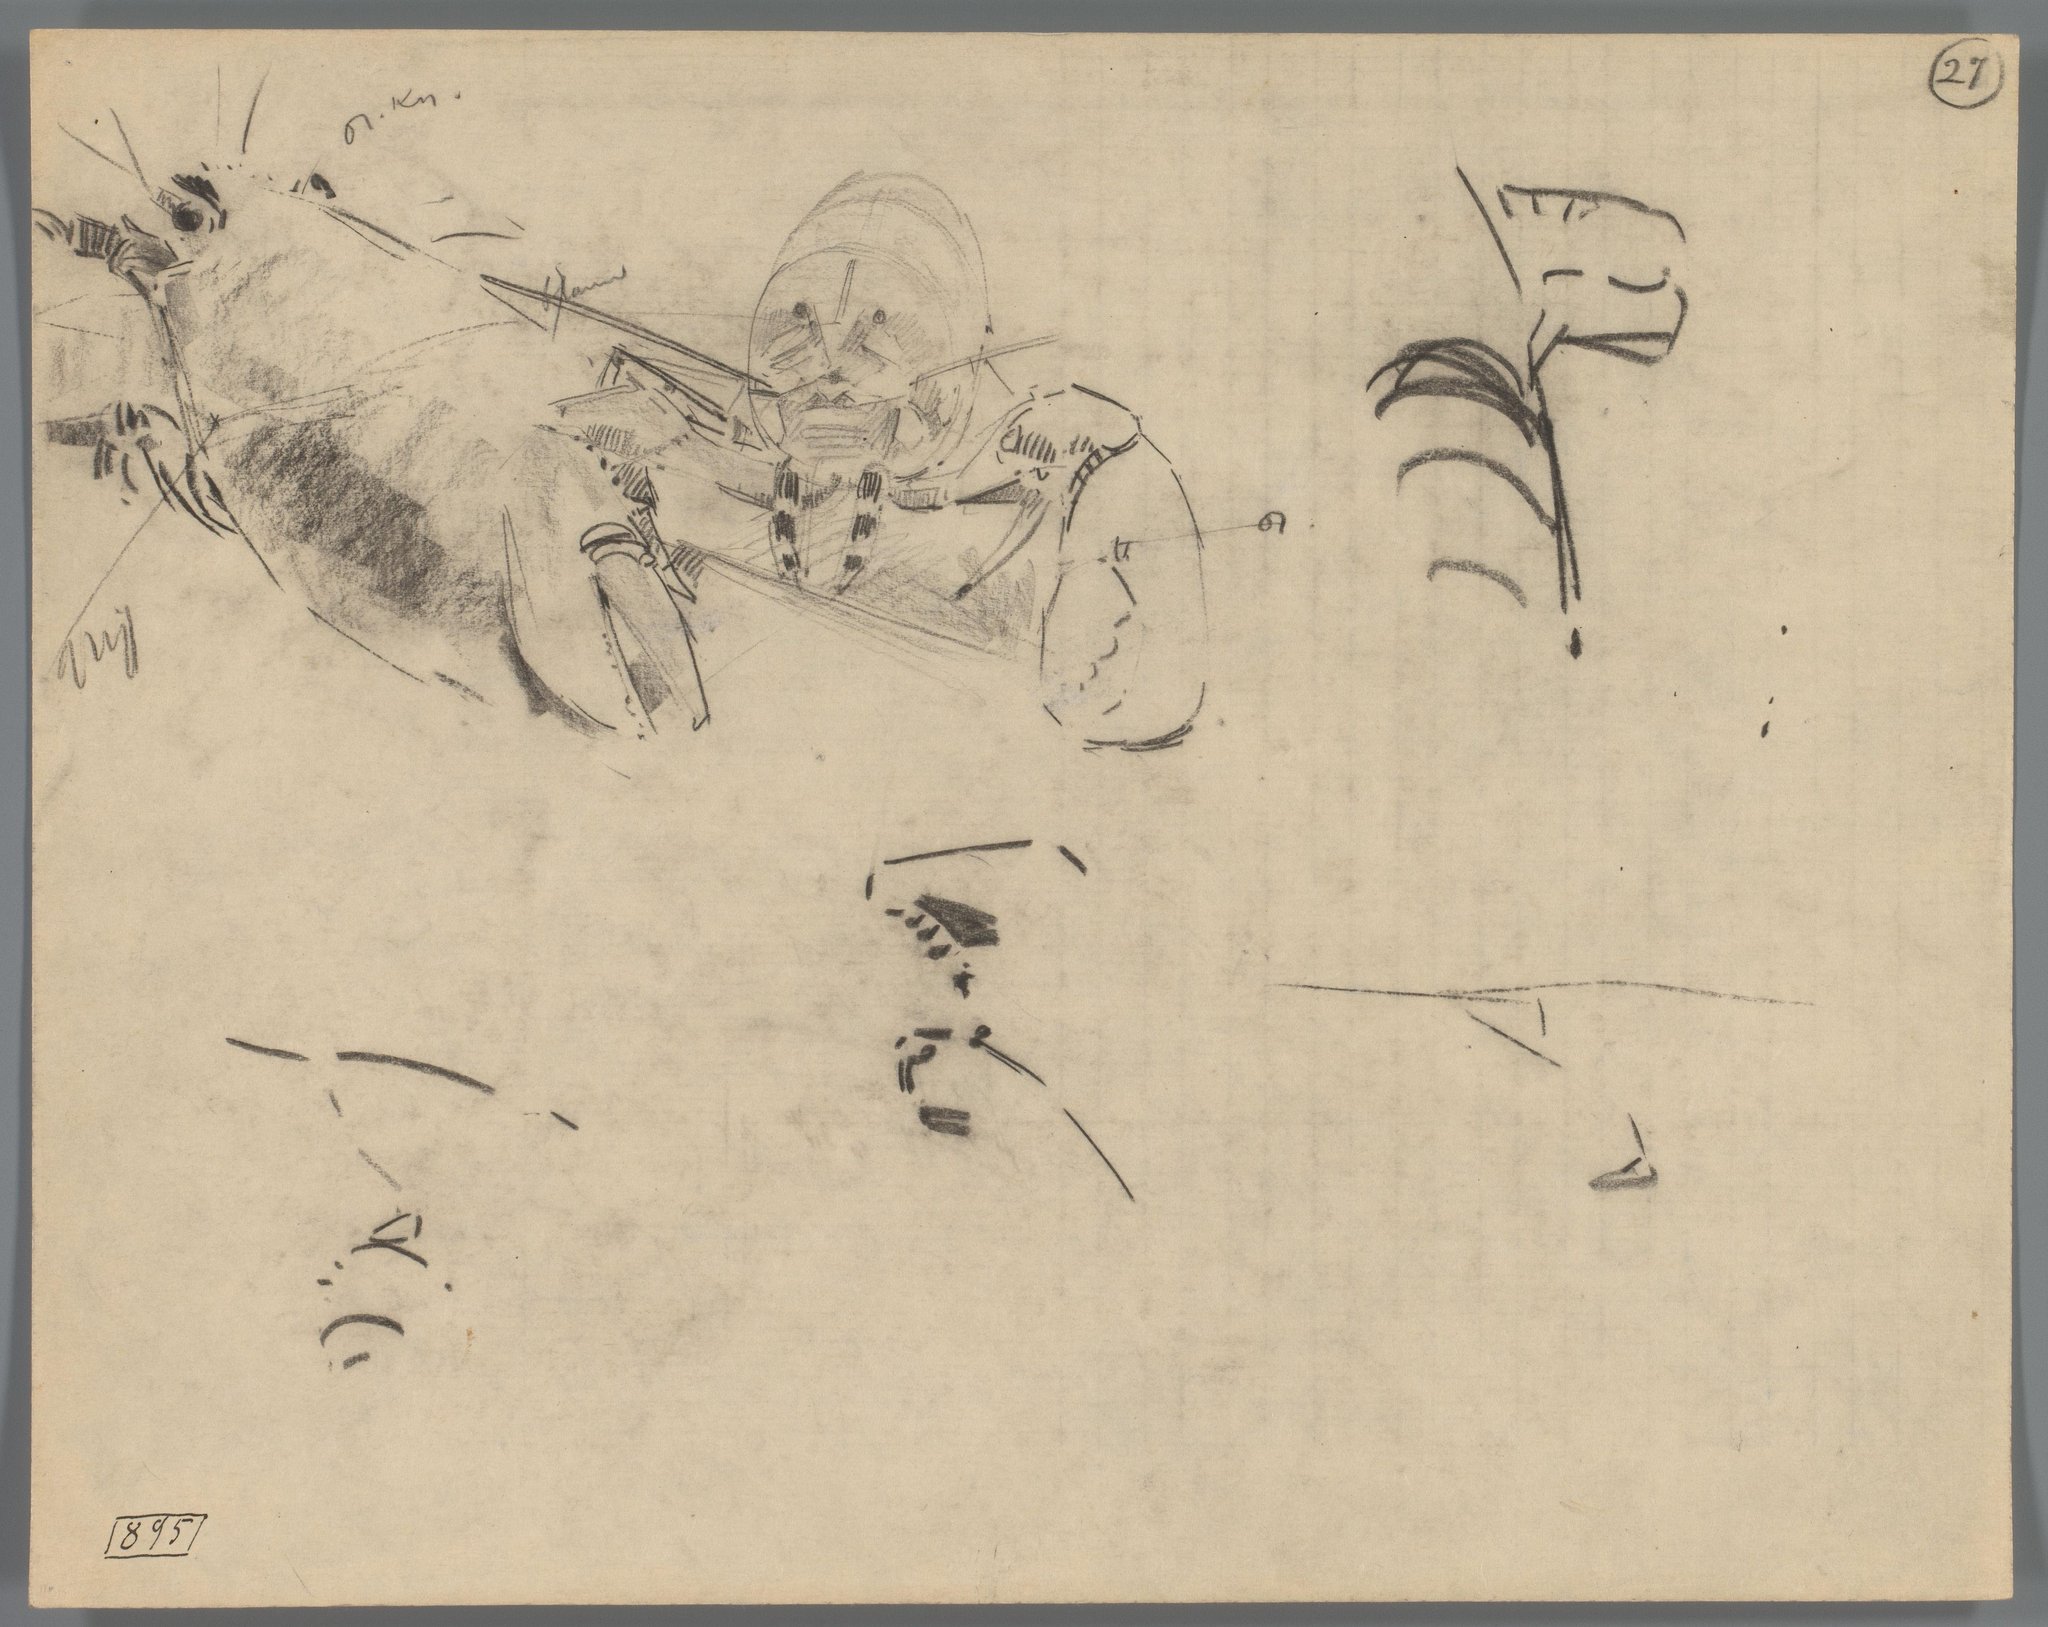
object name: drawing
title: Studie van het kopsborststuk van een kreeft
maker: gerrit willem dijsselhof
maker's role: designer, draughtsman, print maker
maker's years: 1866-1924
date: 1876-1924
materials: chalk, paper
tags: crustaceans: lobster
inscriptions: number: ‘895’, number: ‘27’